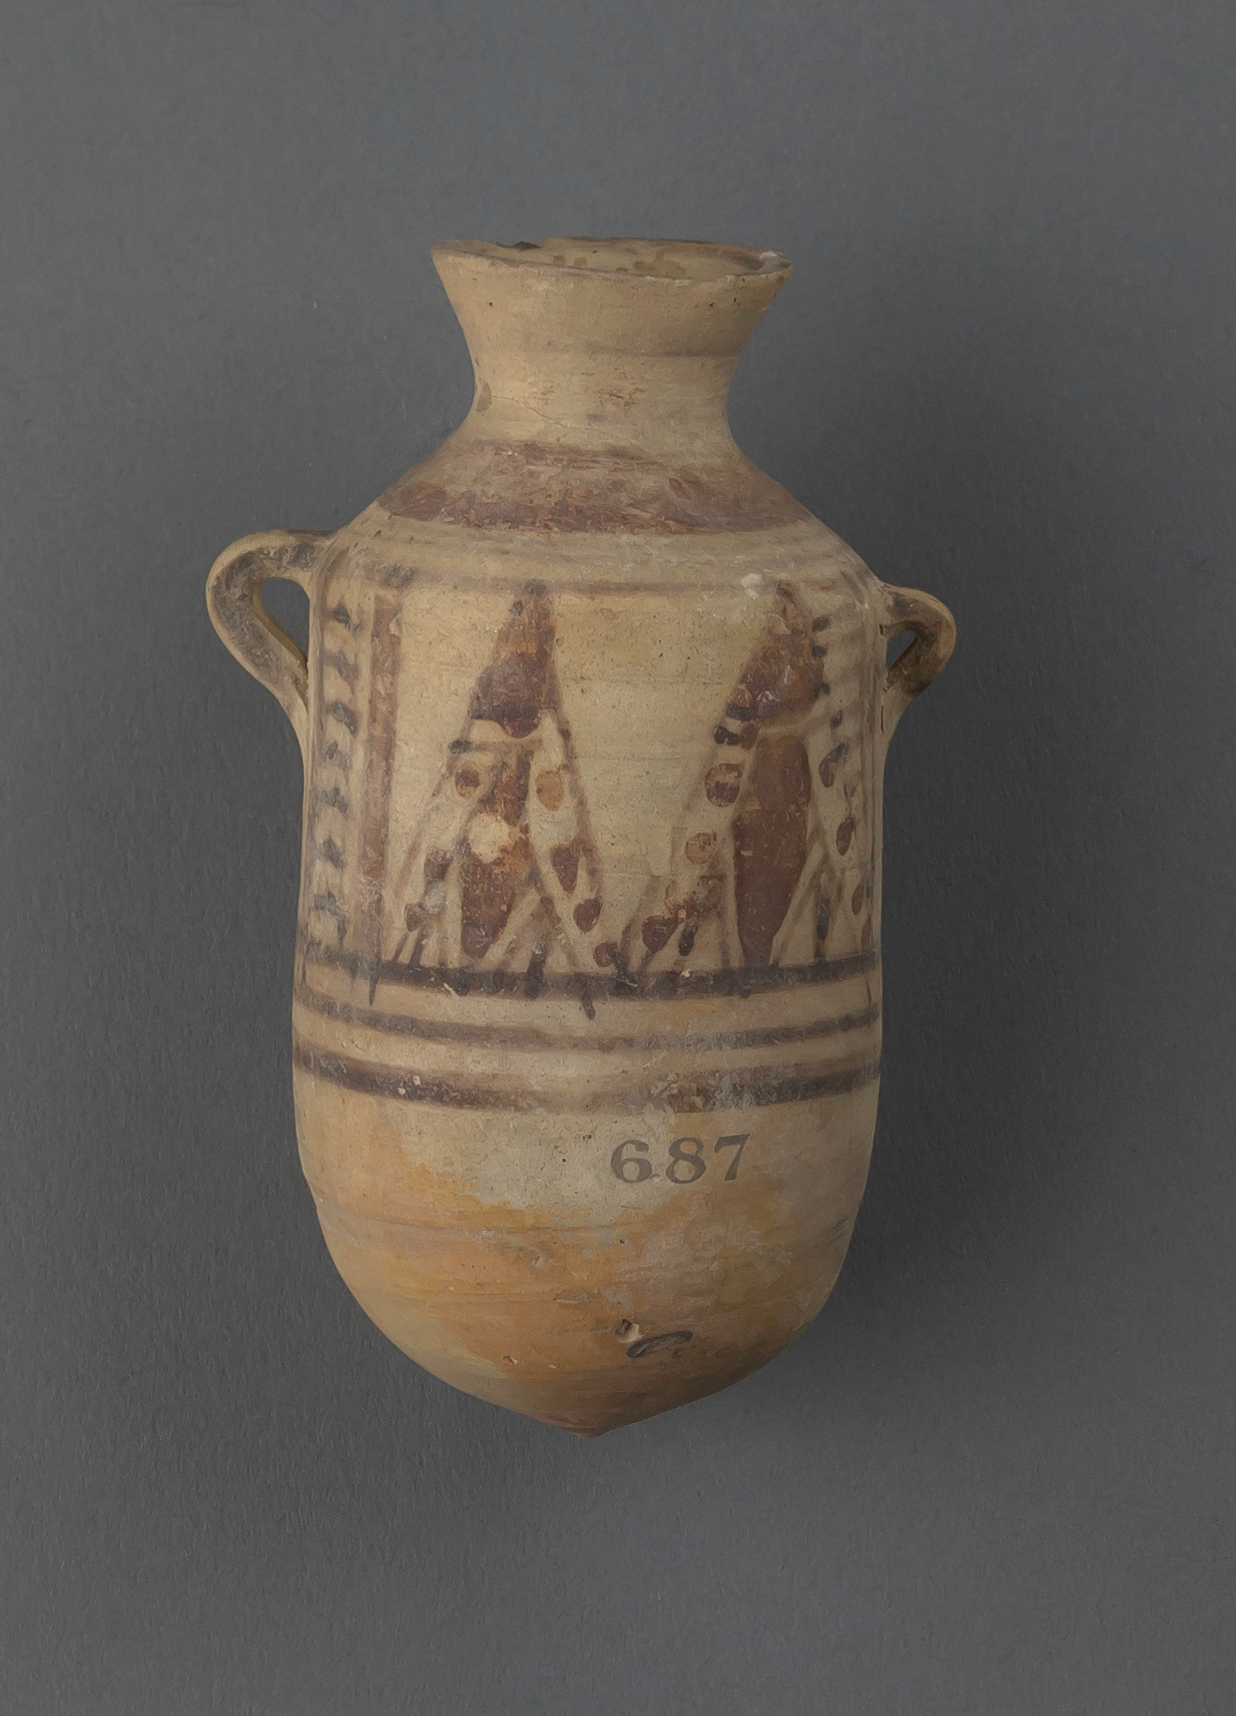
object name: flask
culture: cypriot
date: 600-480 BCE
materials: terracotta